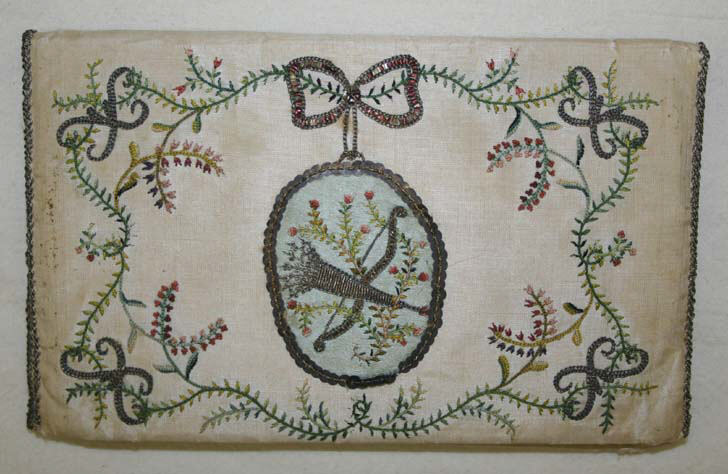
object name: purse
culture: french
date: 1767-1800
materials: metal, silk